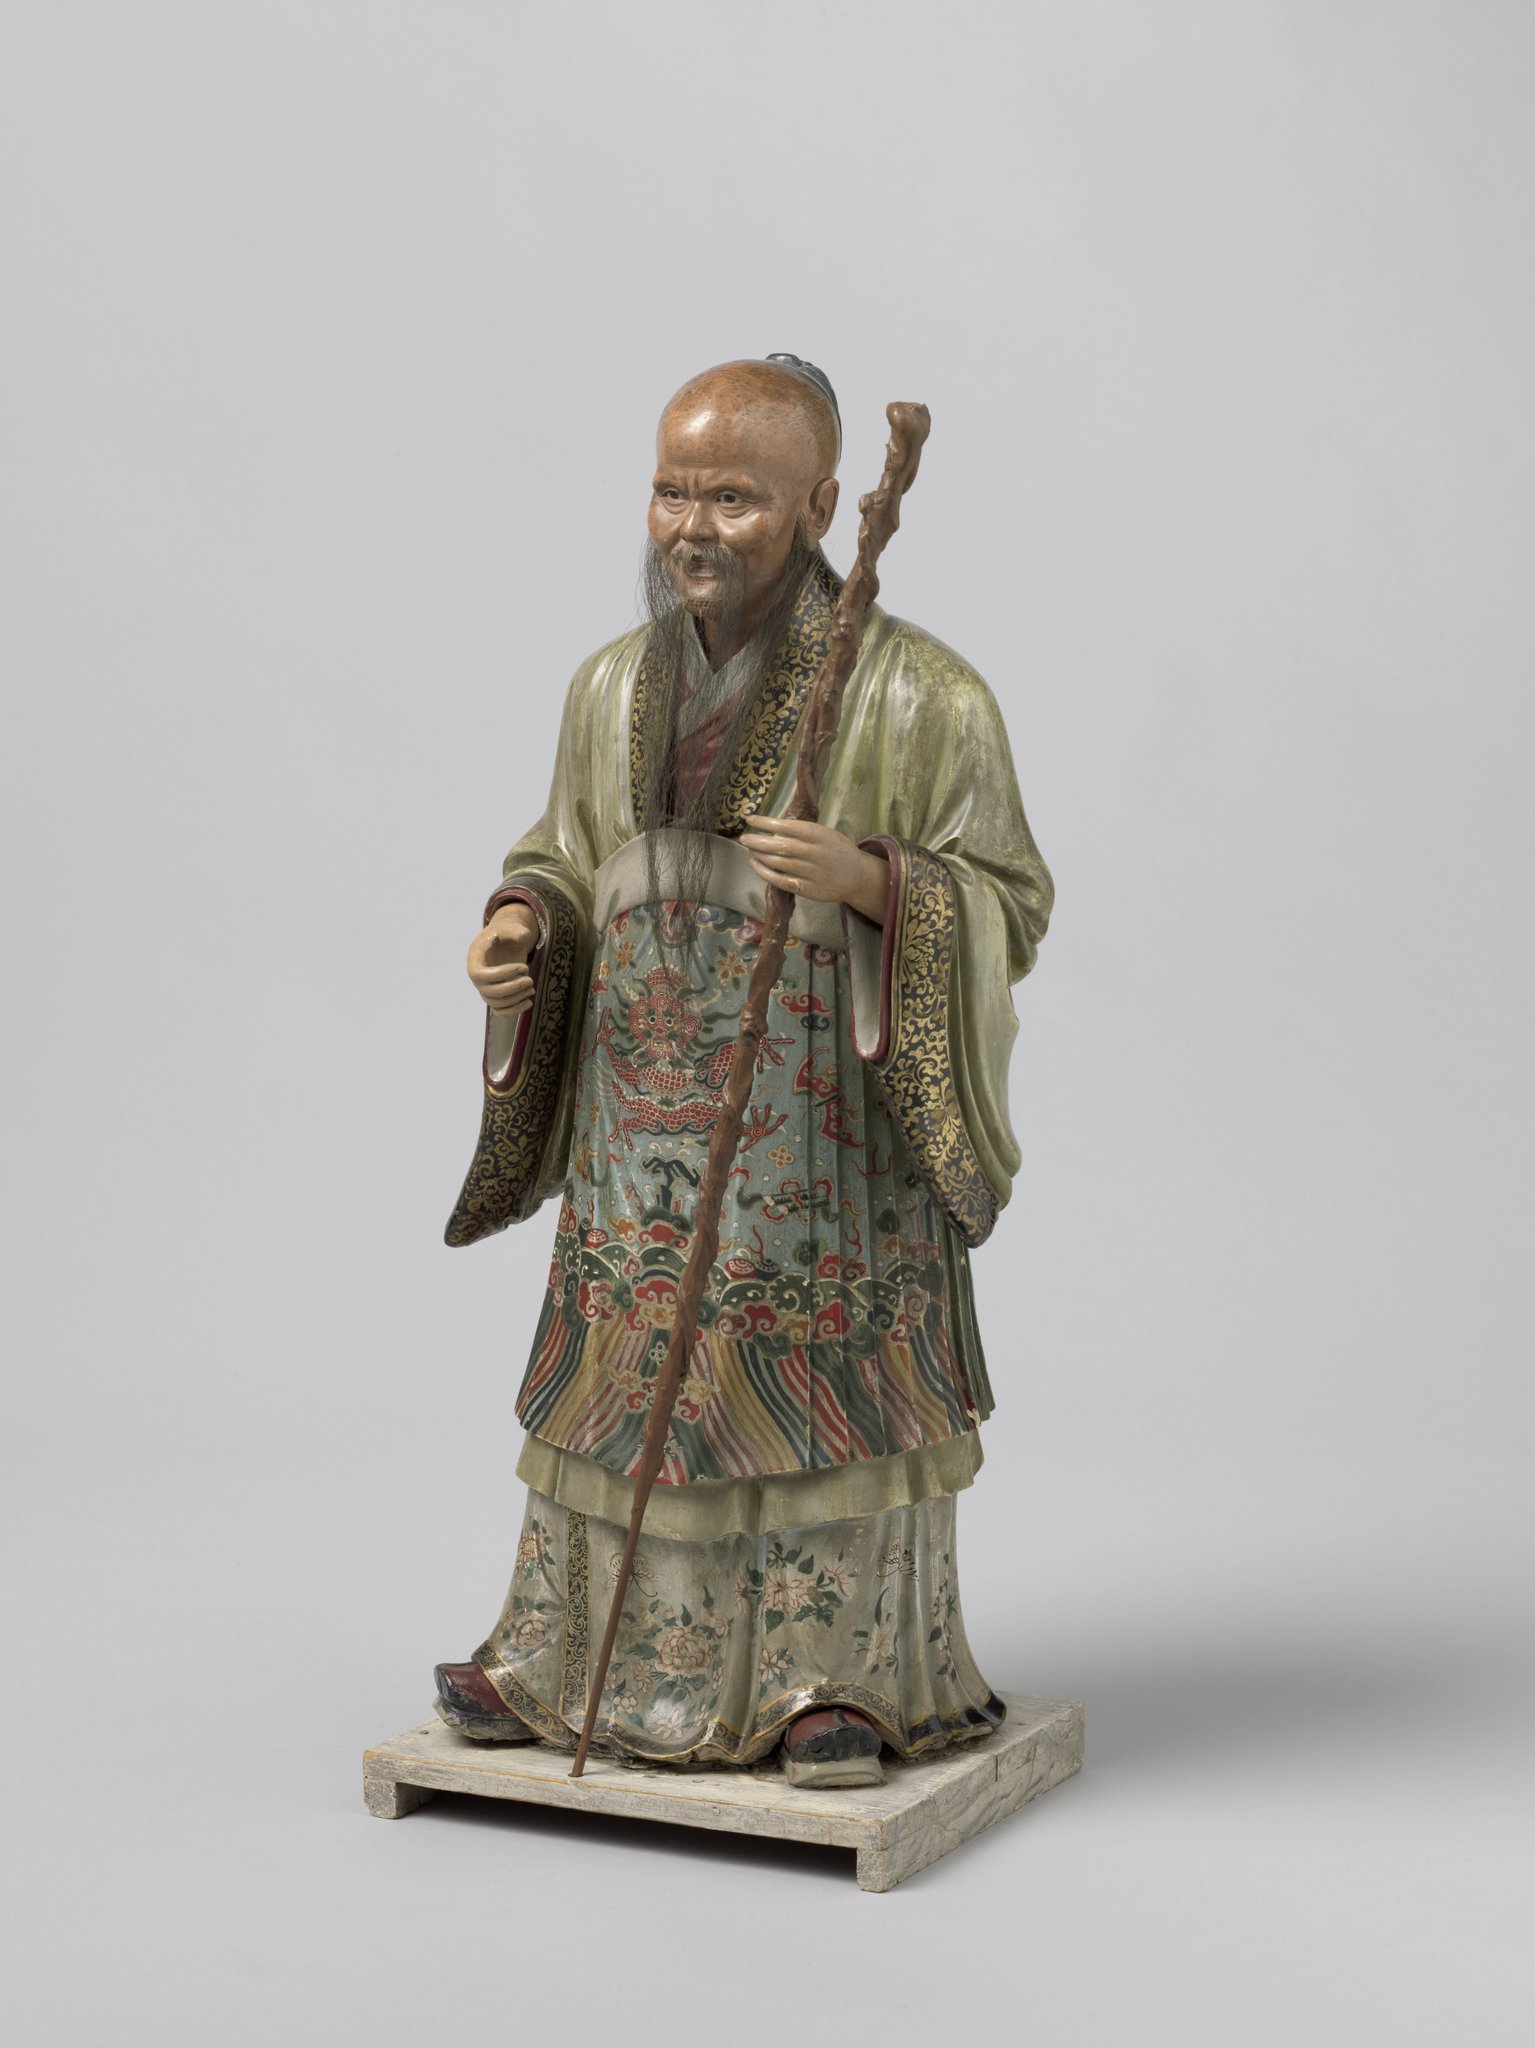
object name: knikpop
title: Staf van een staande Chinese knikpop (man)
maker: Anonymous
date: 1804-1808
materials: hair, iron, lead, earth, porcelain, wood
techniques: woodworking, molding, polychromy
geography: china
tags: china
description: Geschenk van de Keizer van China aan A.H. van Limburg Brouwer, Lid van de Raad der Aziatische Bezittingen en Etablissementen tijdens de Bataafse Republiek.